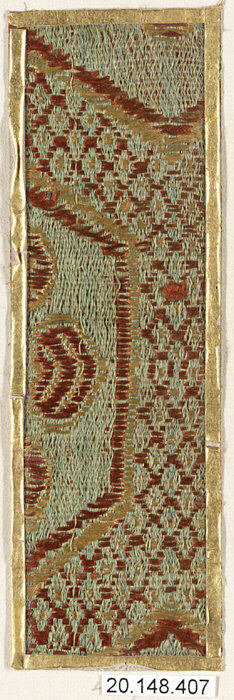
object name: piece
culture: japanese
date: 1801-1900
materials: silk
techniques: compound weave